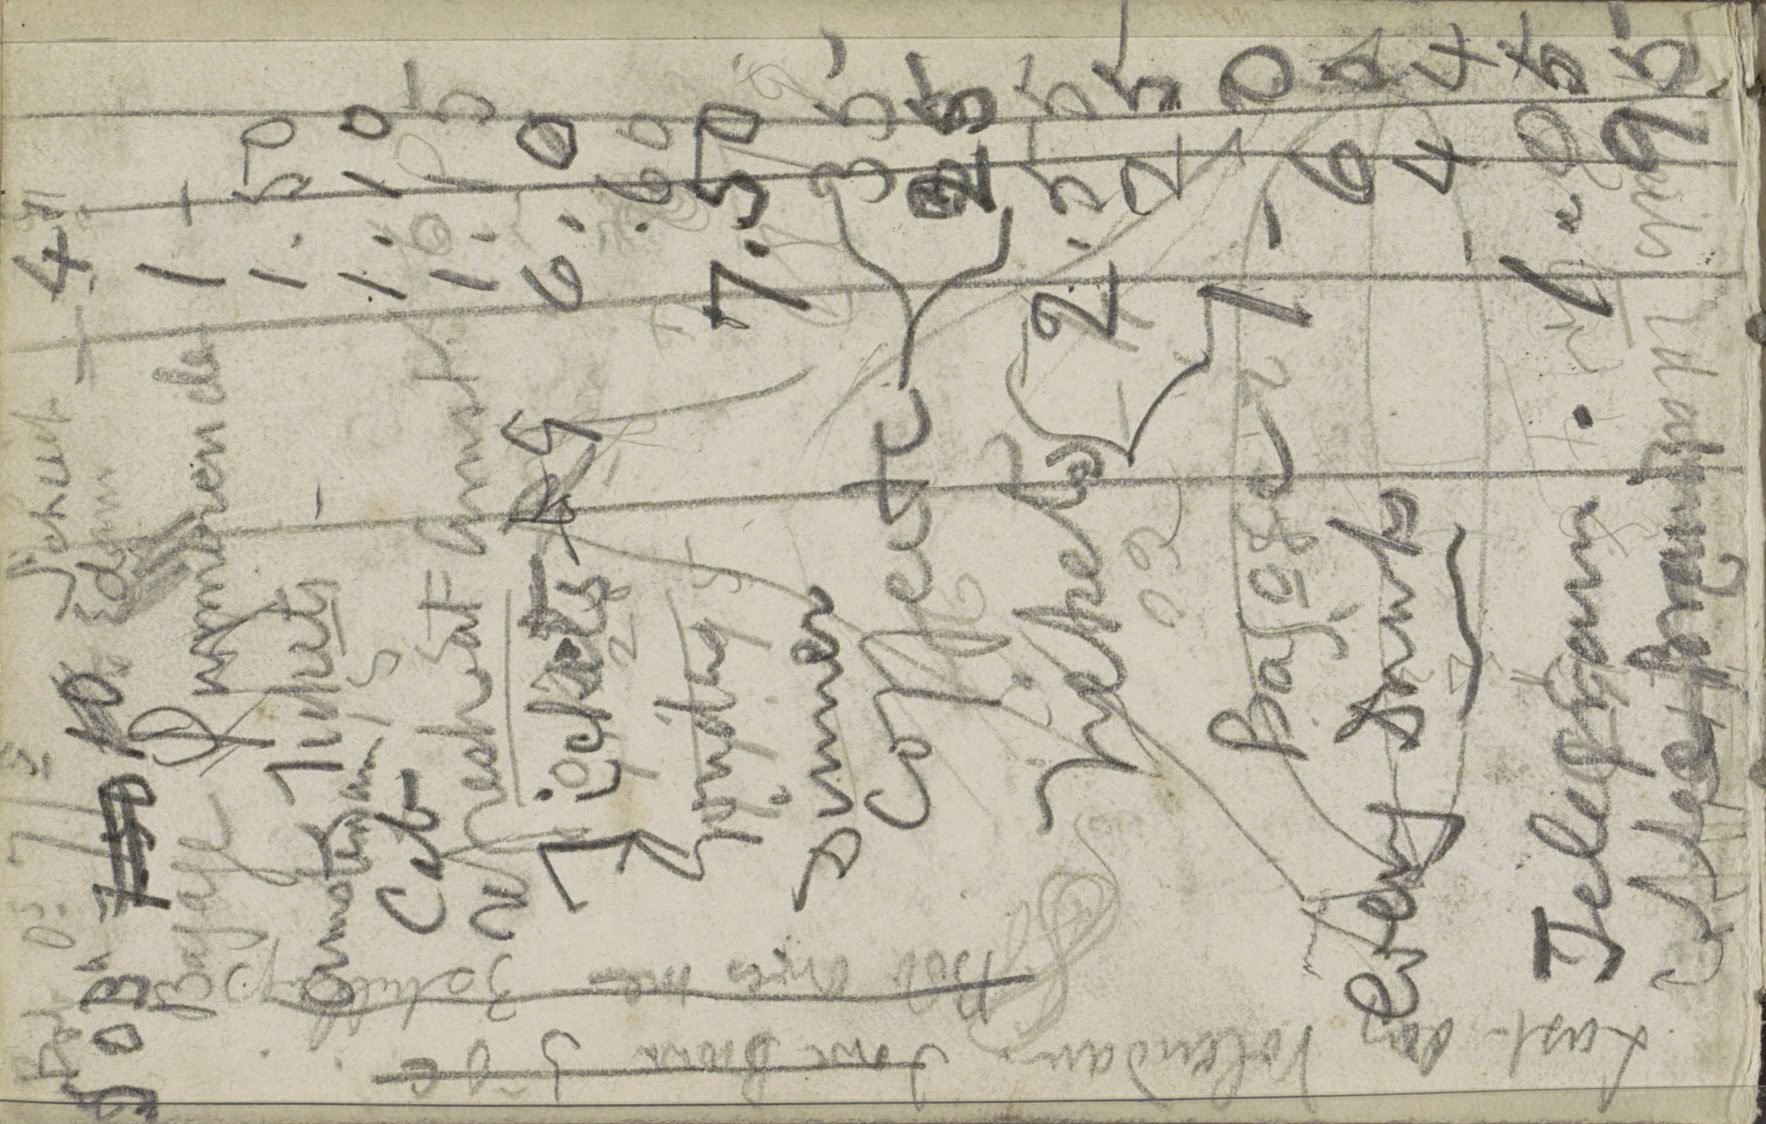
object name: sketchbook leaf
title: Reisnotities en berekeningen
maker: george clausen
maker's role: draughtsman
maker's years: 1852-1912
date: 1875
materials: paper, pencil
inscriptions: annotation: ‘[...]’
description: Blad 38 recto uit een schetsboek met 38 bladen.